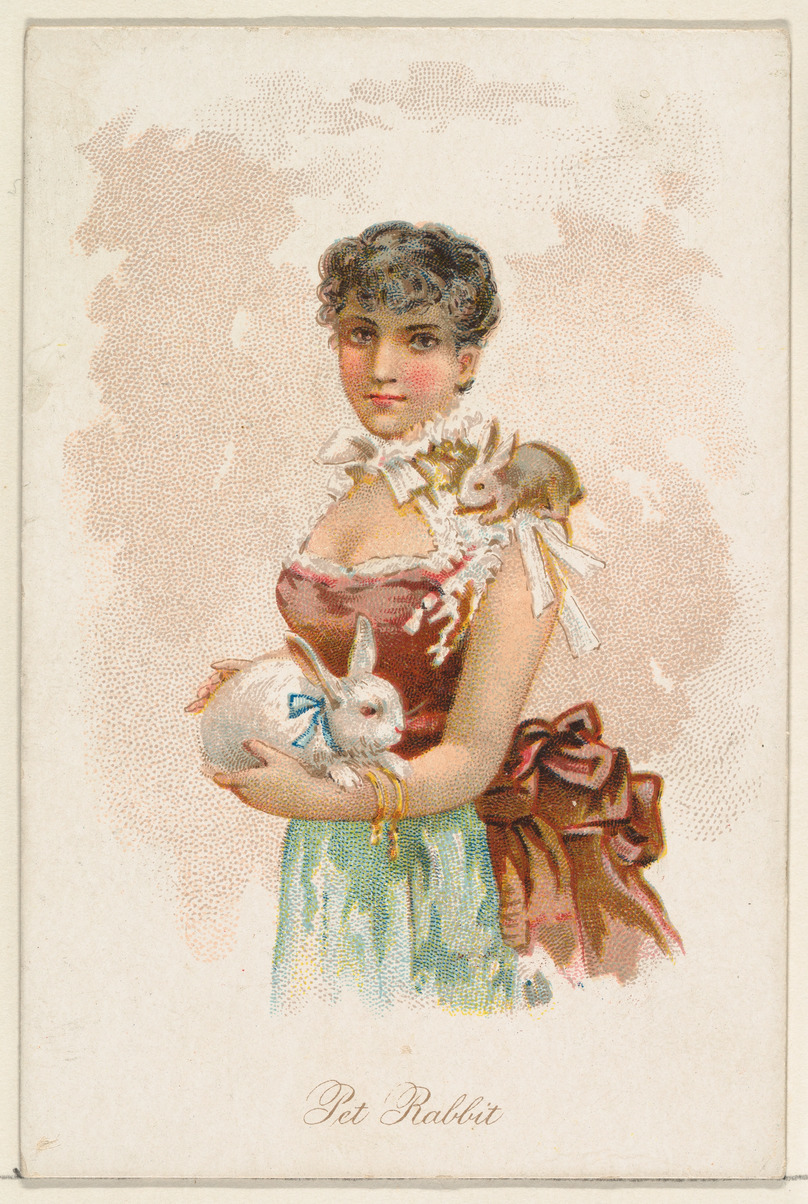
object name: print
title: Pet Rabbit, from the Household Pets series (N194) issued by Wm. S. Kimball & Co.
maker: william s. kimball & company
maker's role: publisher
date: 1891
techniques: color lithograph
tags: women,rabbits